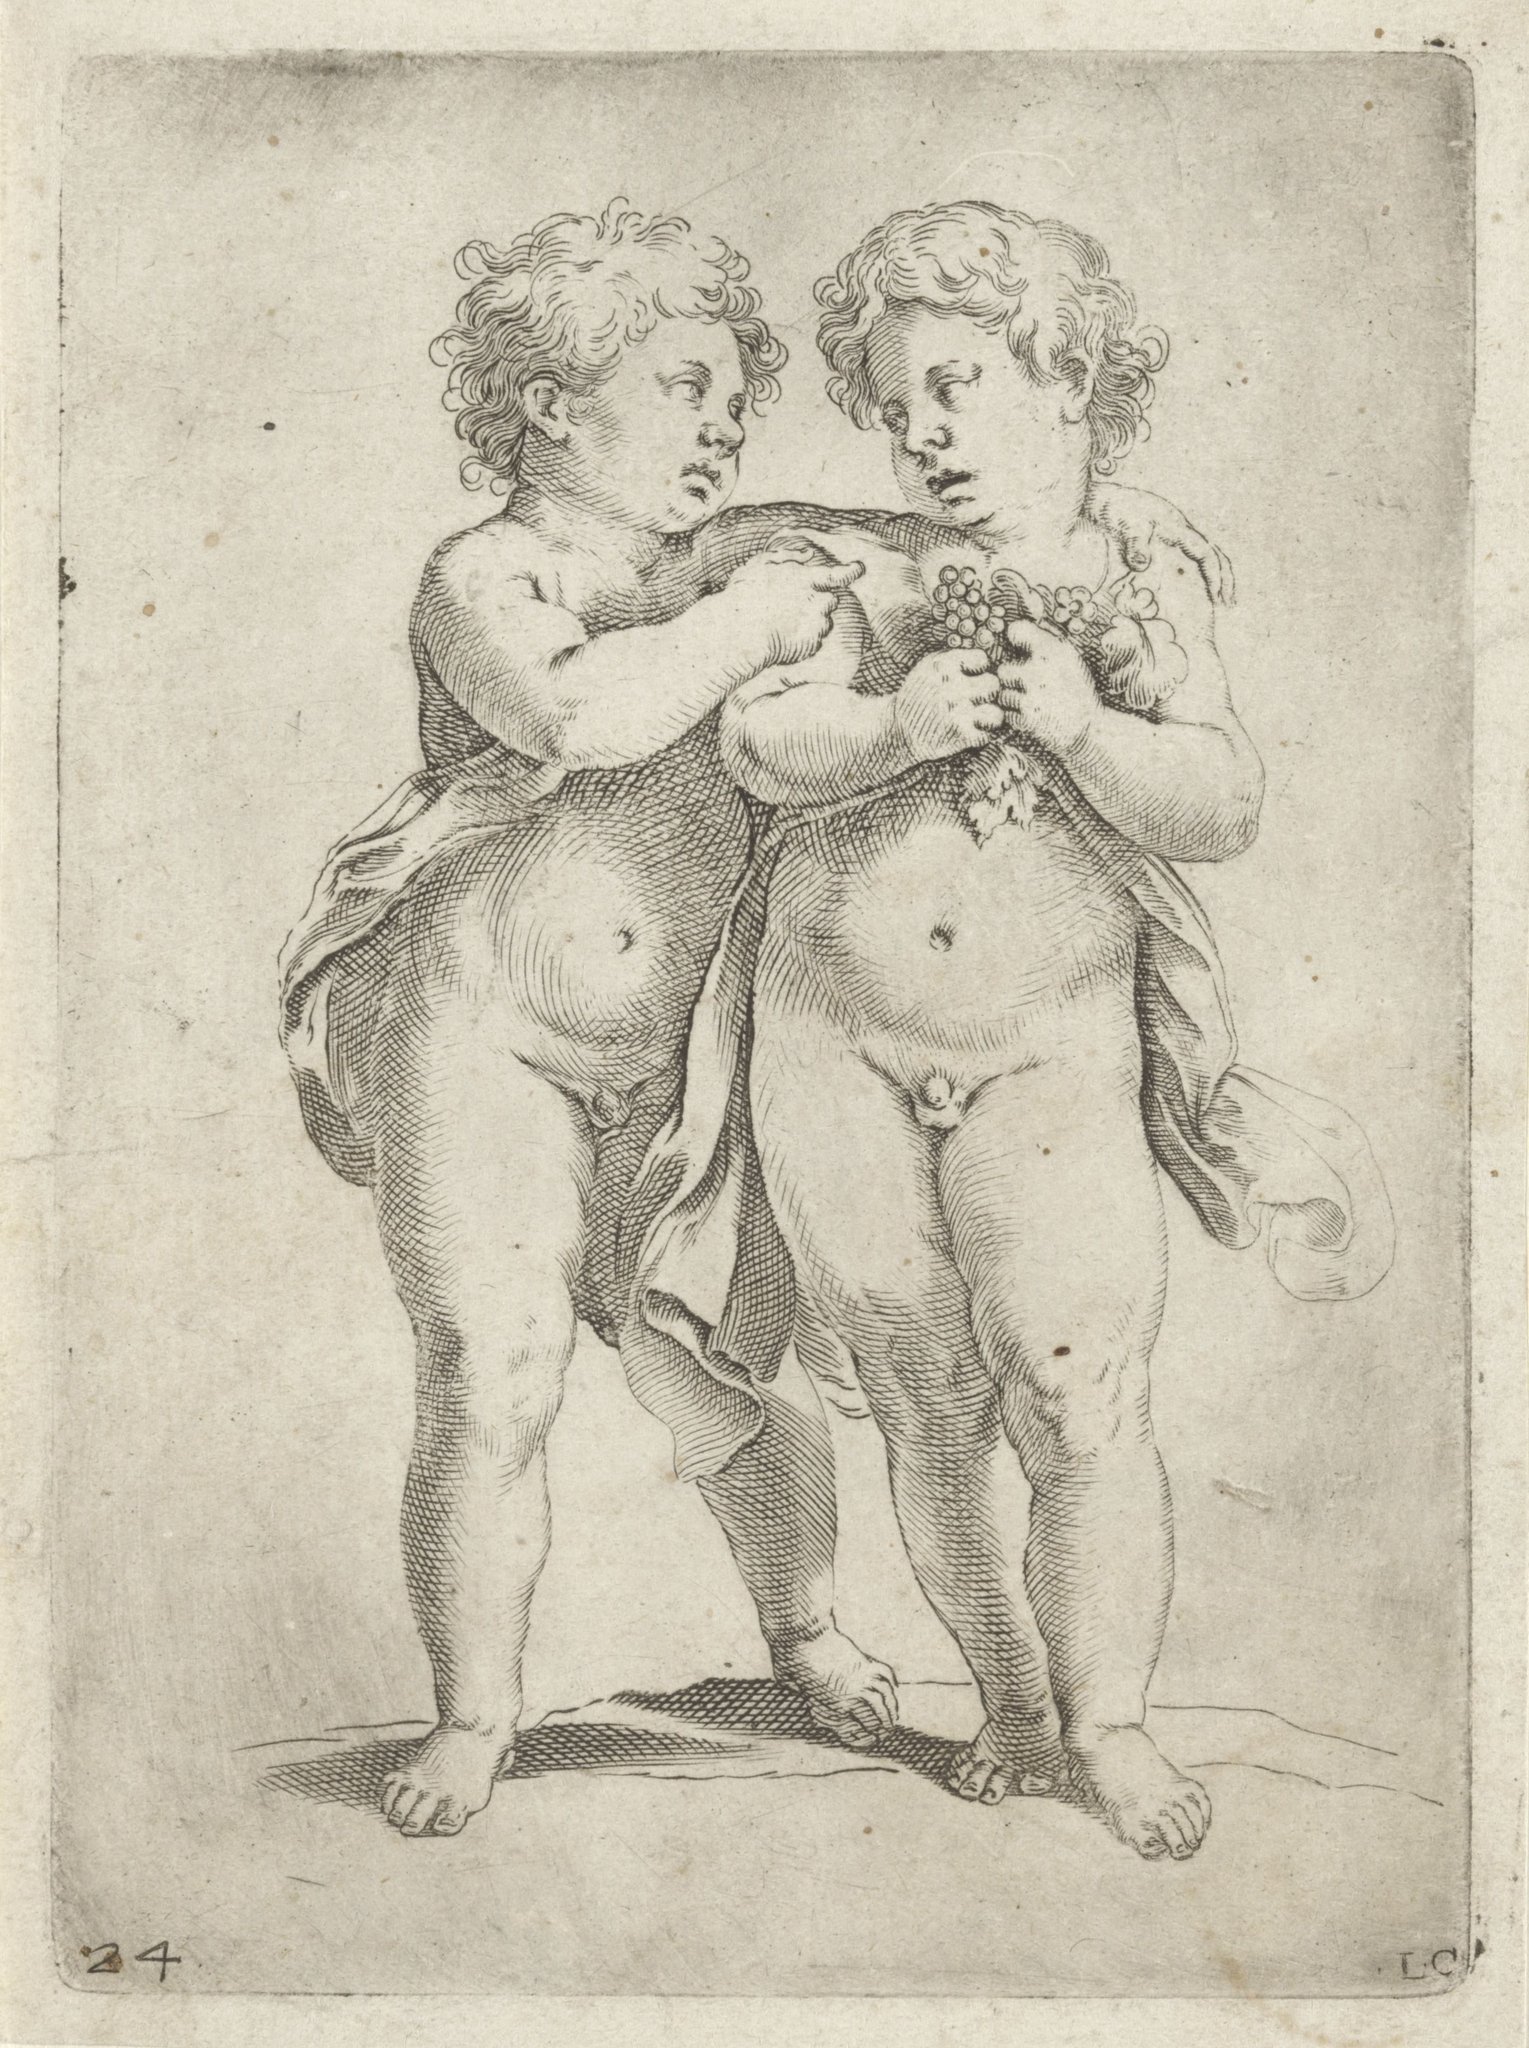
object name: print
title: Twee jongetjes, waarvan een met tros druiven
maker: luca ciamberlano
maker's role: painter, print maker, publisher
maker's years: 1570-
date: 1580-1641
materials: paper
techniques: engraving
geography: italy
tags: cupids: 'amores', 'amoretti', 'putti'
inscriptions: collector's mark: Lugt 240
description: Twee staande jongetjes naast elkaar. Een houdt een tros druiven in zijn handen. Genummerd linksonder: 24.